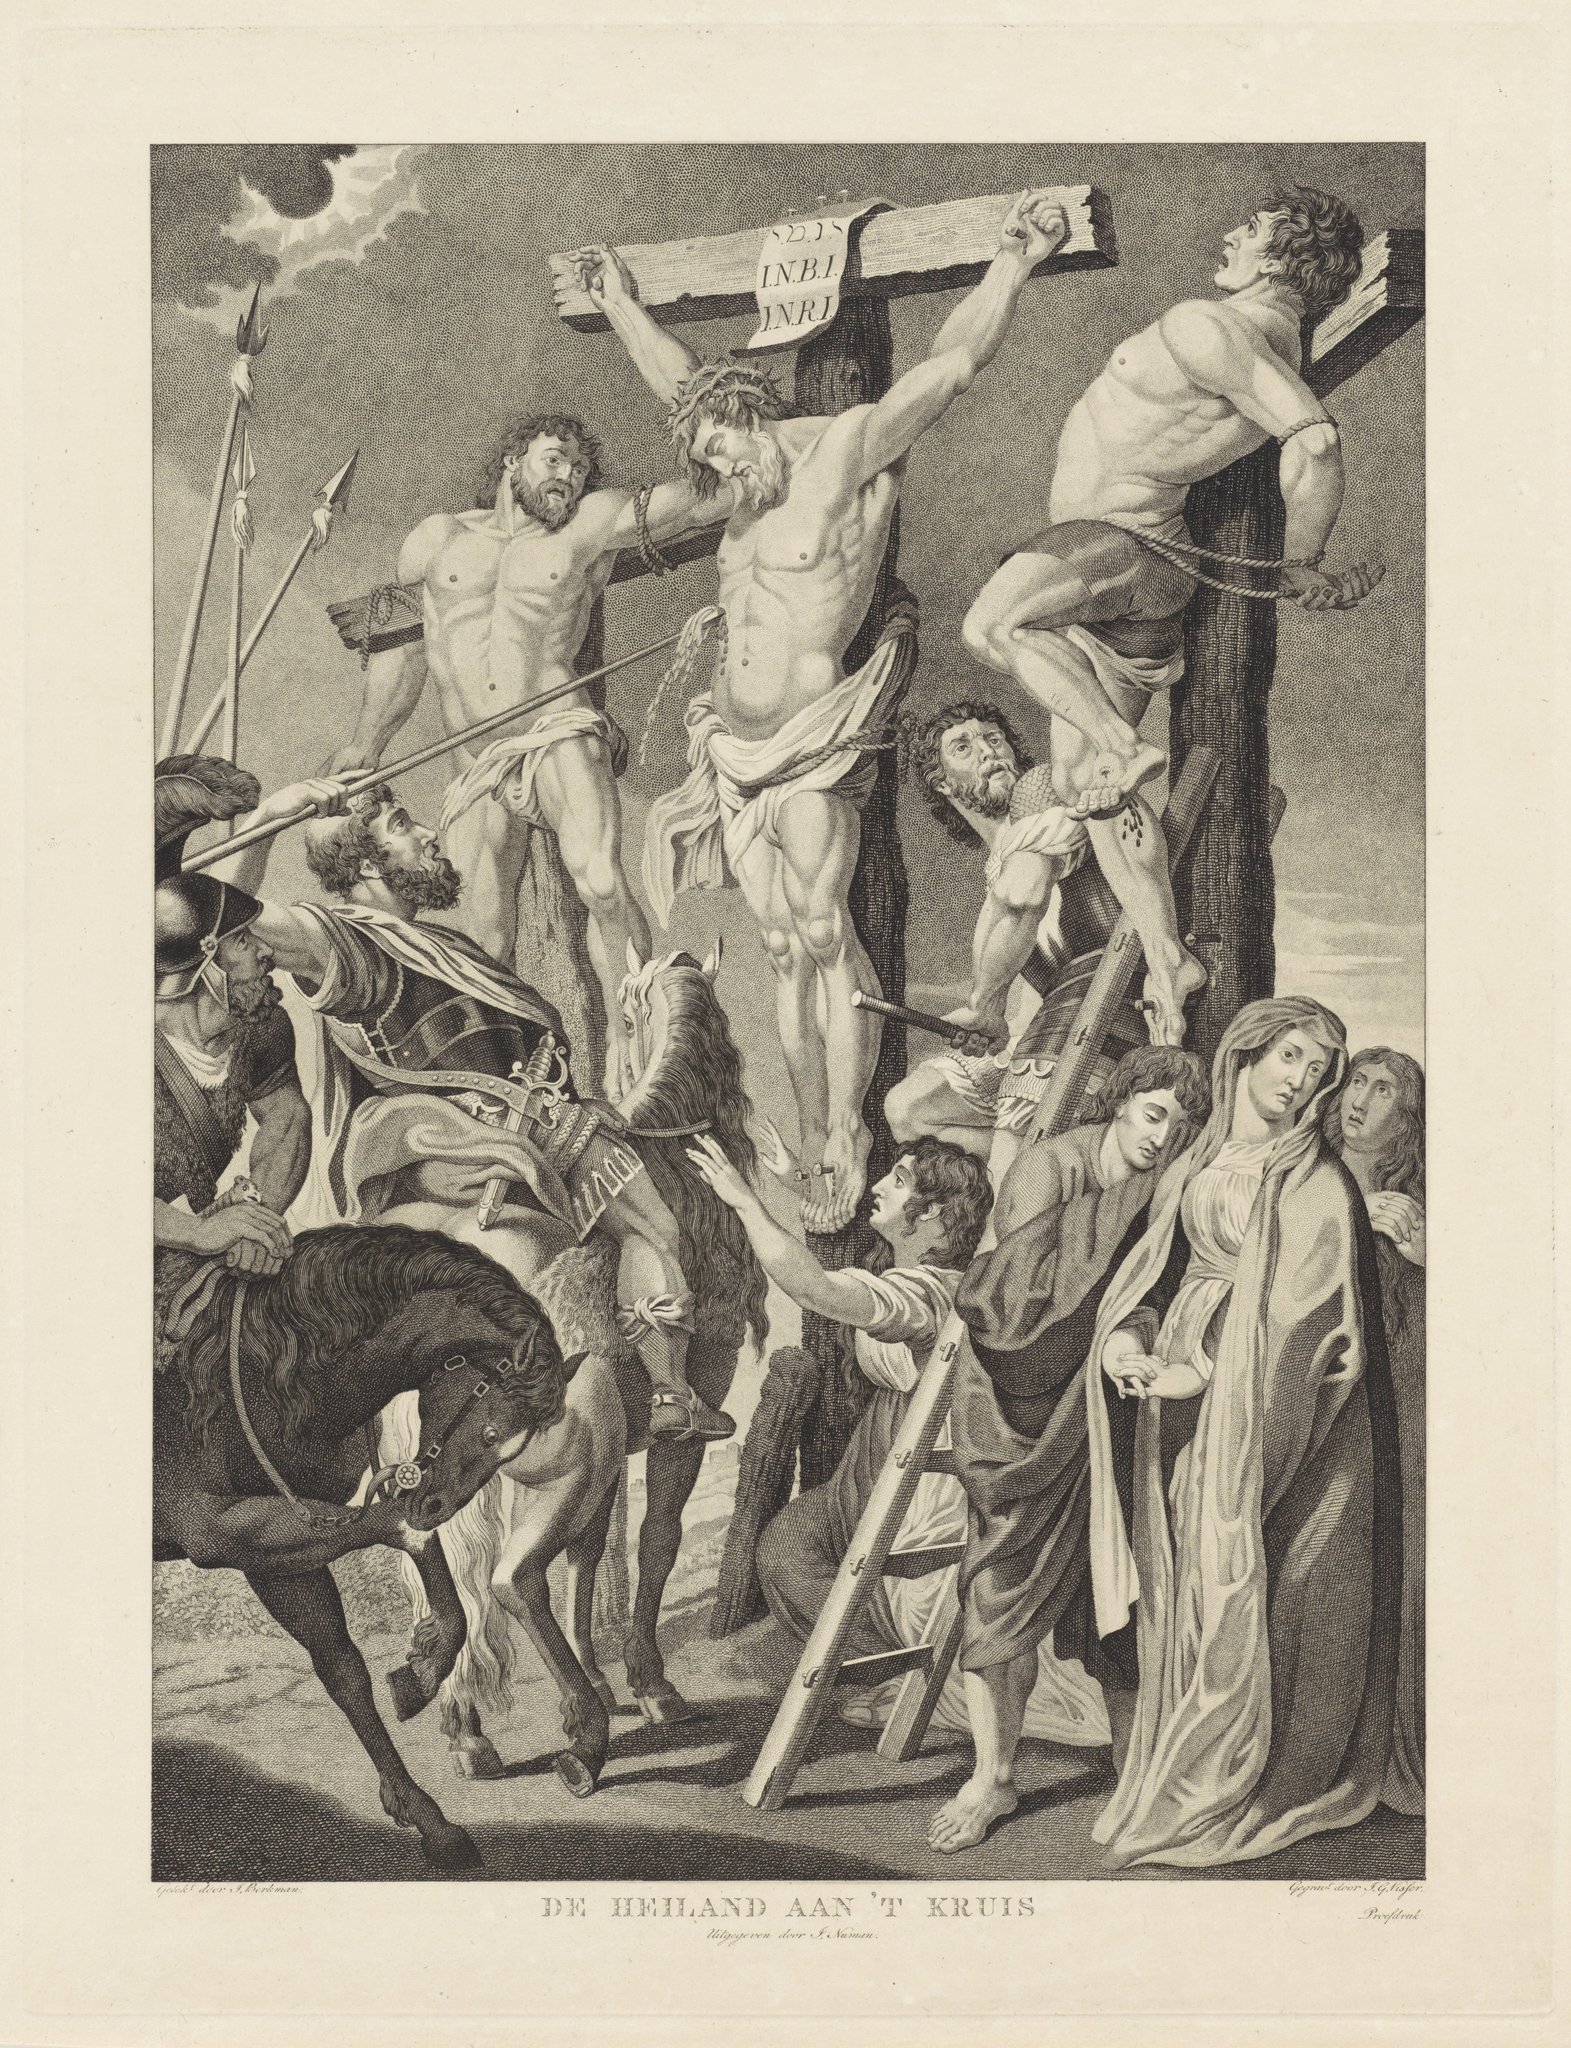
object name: print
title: De Heiland aan 't kruis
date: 1812-1821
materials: paper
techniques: engraving, etching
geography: amsterdam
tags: christ on the cross; only scenes following the crucifixion added - dd - the three crosses (+ mary), longinus pierces christ's side with a lance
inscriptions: collector's mark: Lugt 2233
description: Christus aan het kruis, met naast hem de twee gekruisigde misdadigers. Onder het kruis Longinus te paard, die zijn speer in de zij van Christus steekt. Rechts Maria en Johannes de Doper.